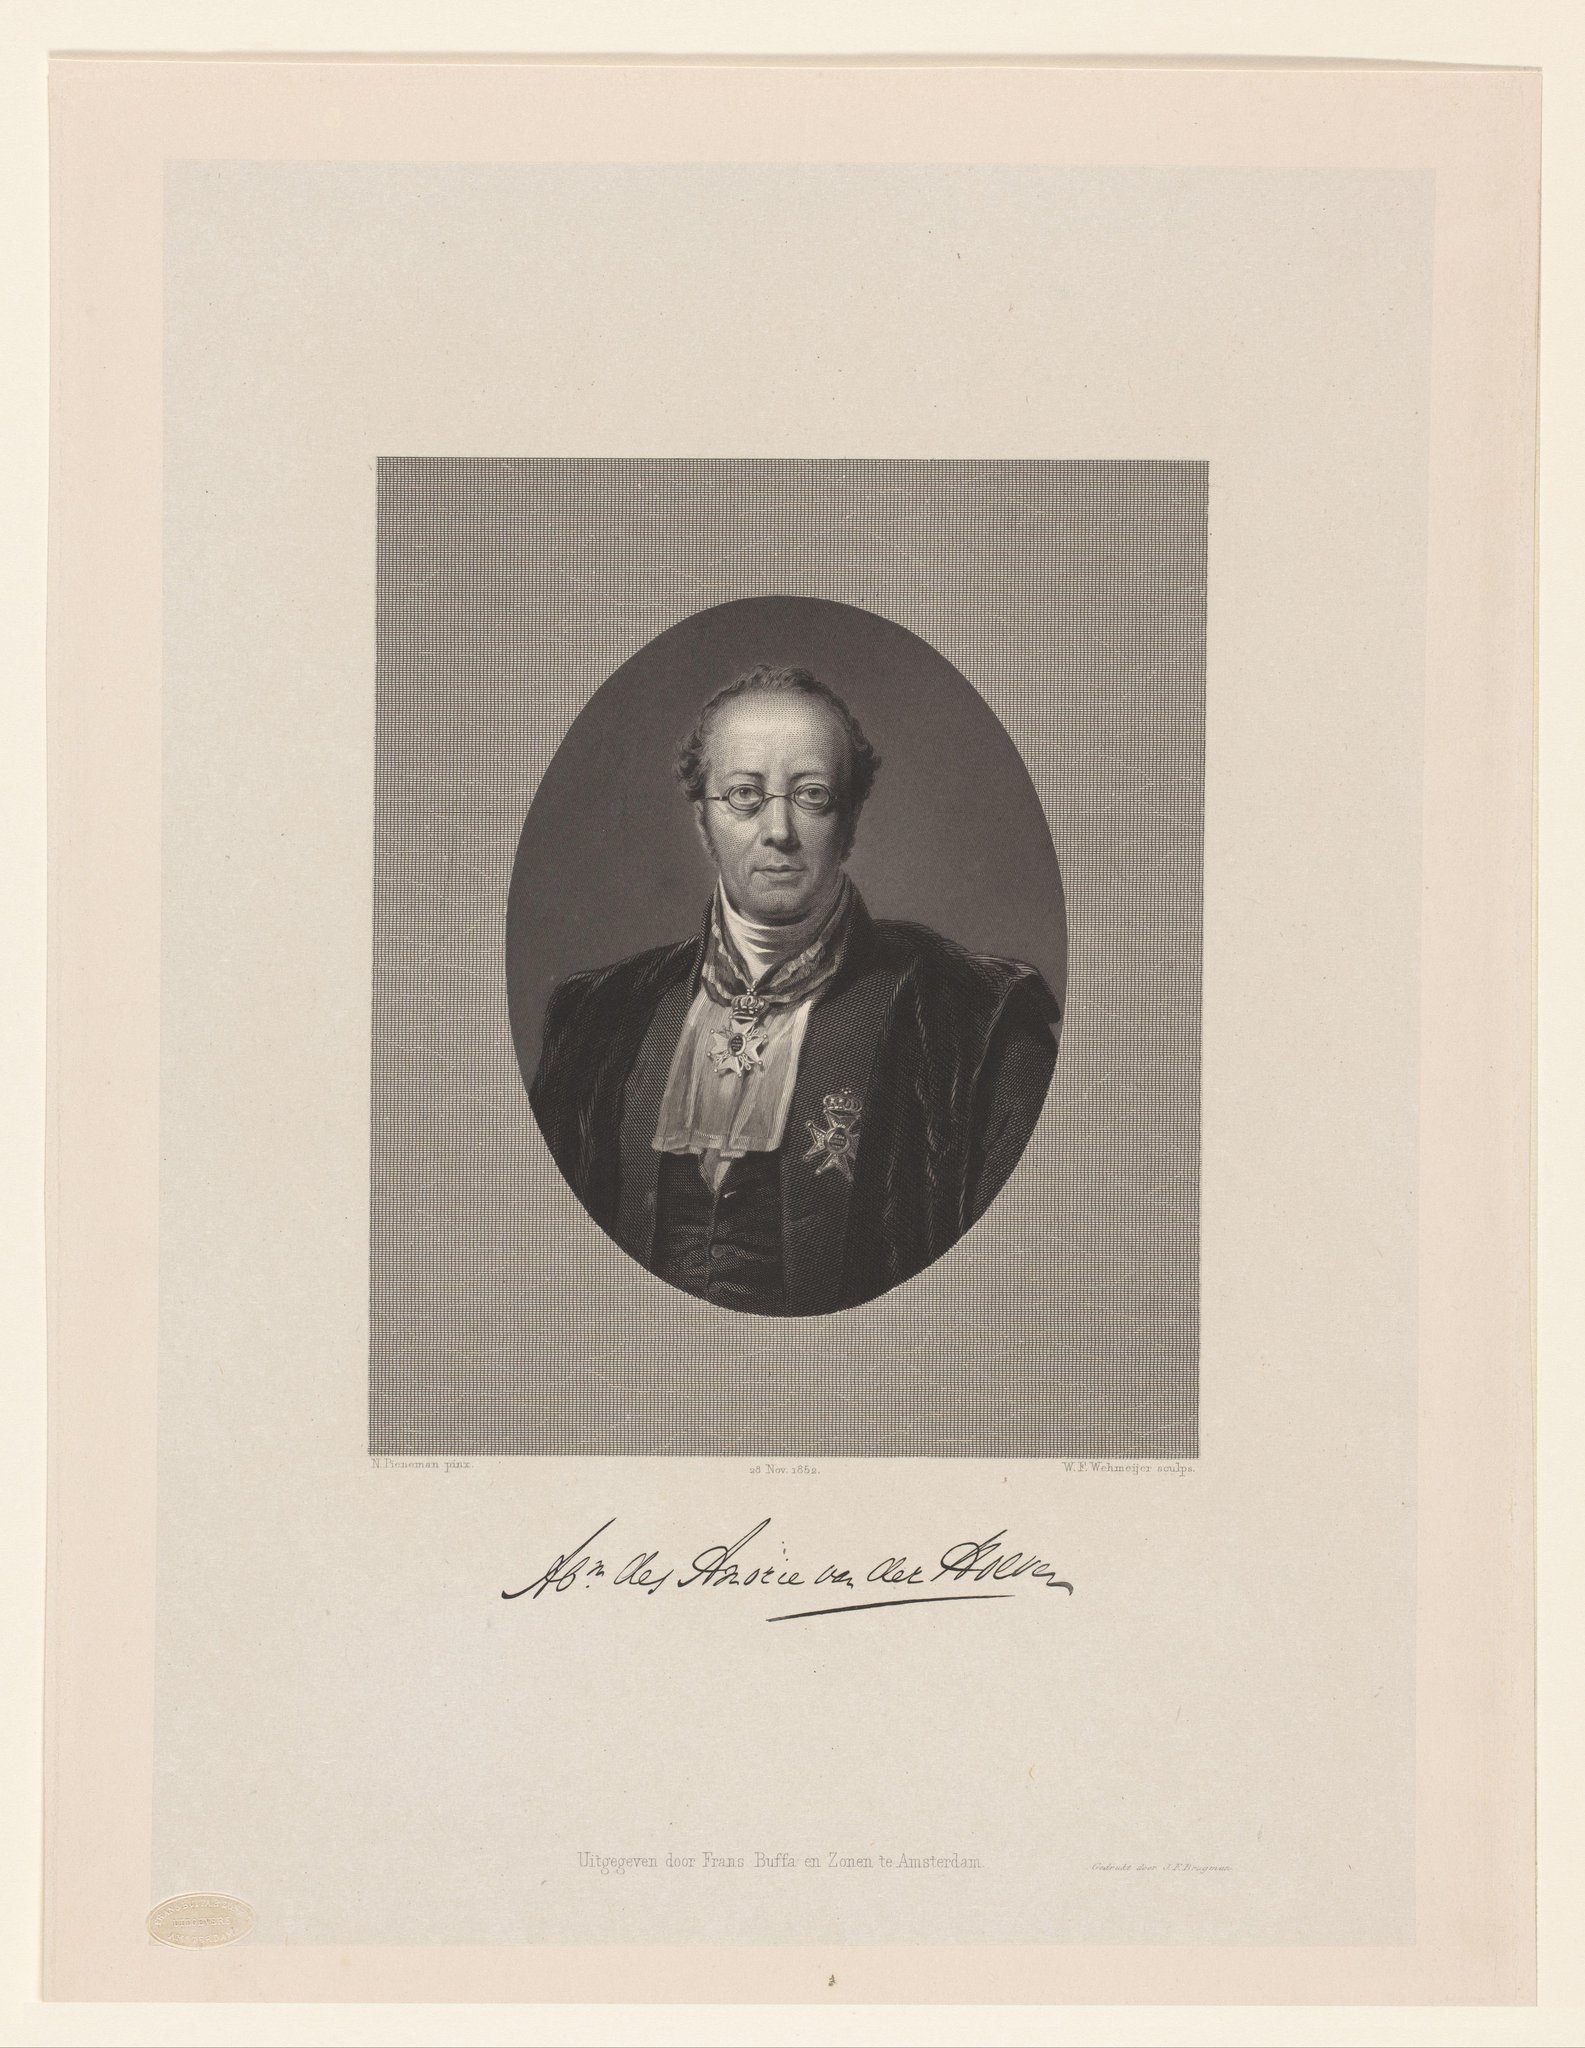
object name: print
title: Portret van Abraham des Amorie van der Hoeven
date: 1852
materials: paper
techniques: engraving, roulette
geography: amsterdam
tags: rotterdam, arnhem, adult man, historical persons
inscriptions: collector's mark: Lugt 2228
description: Portret van Abraham des Amorie van der Hoeven, hoogleraar aan het Remonstrants Seminarium te Amsterdam met het Grootkruis Nederlandse Leeuw om de hals. Onder de voorstelling de signatuur van de geportretteerde.